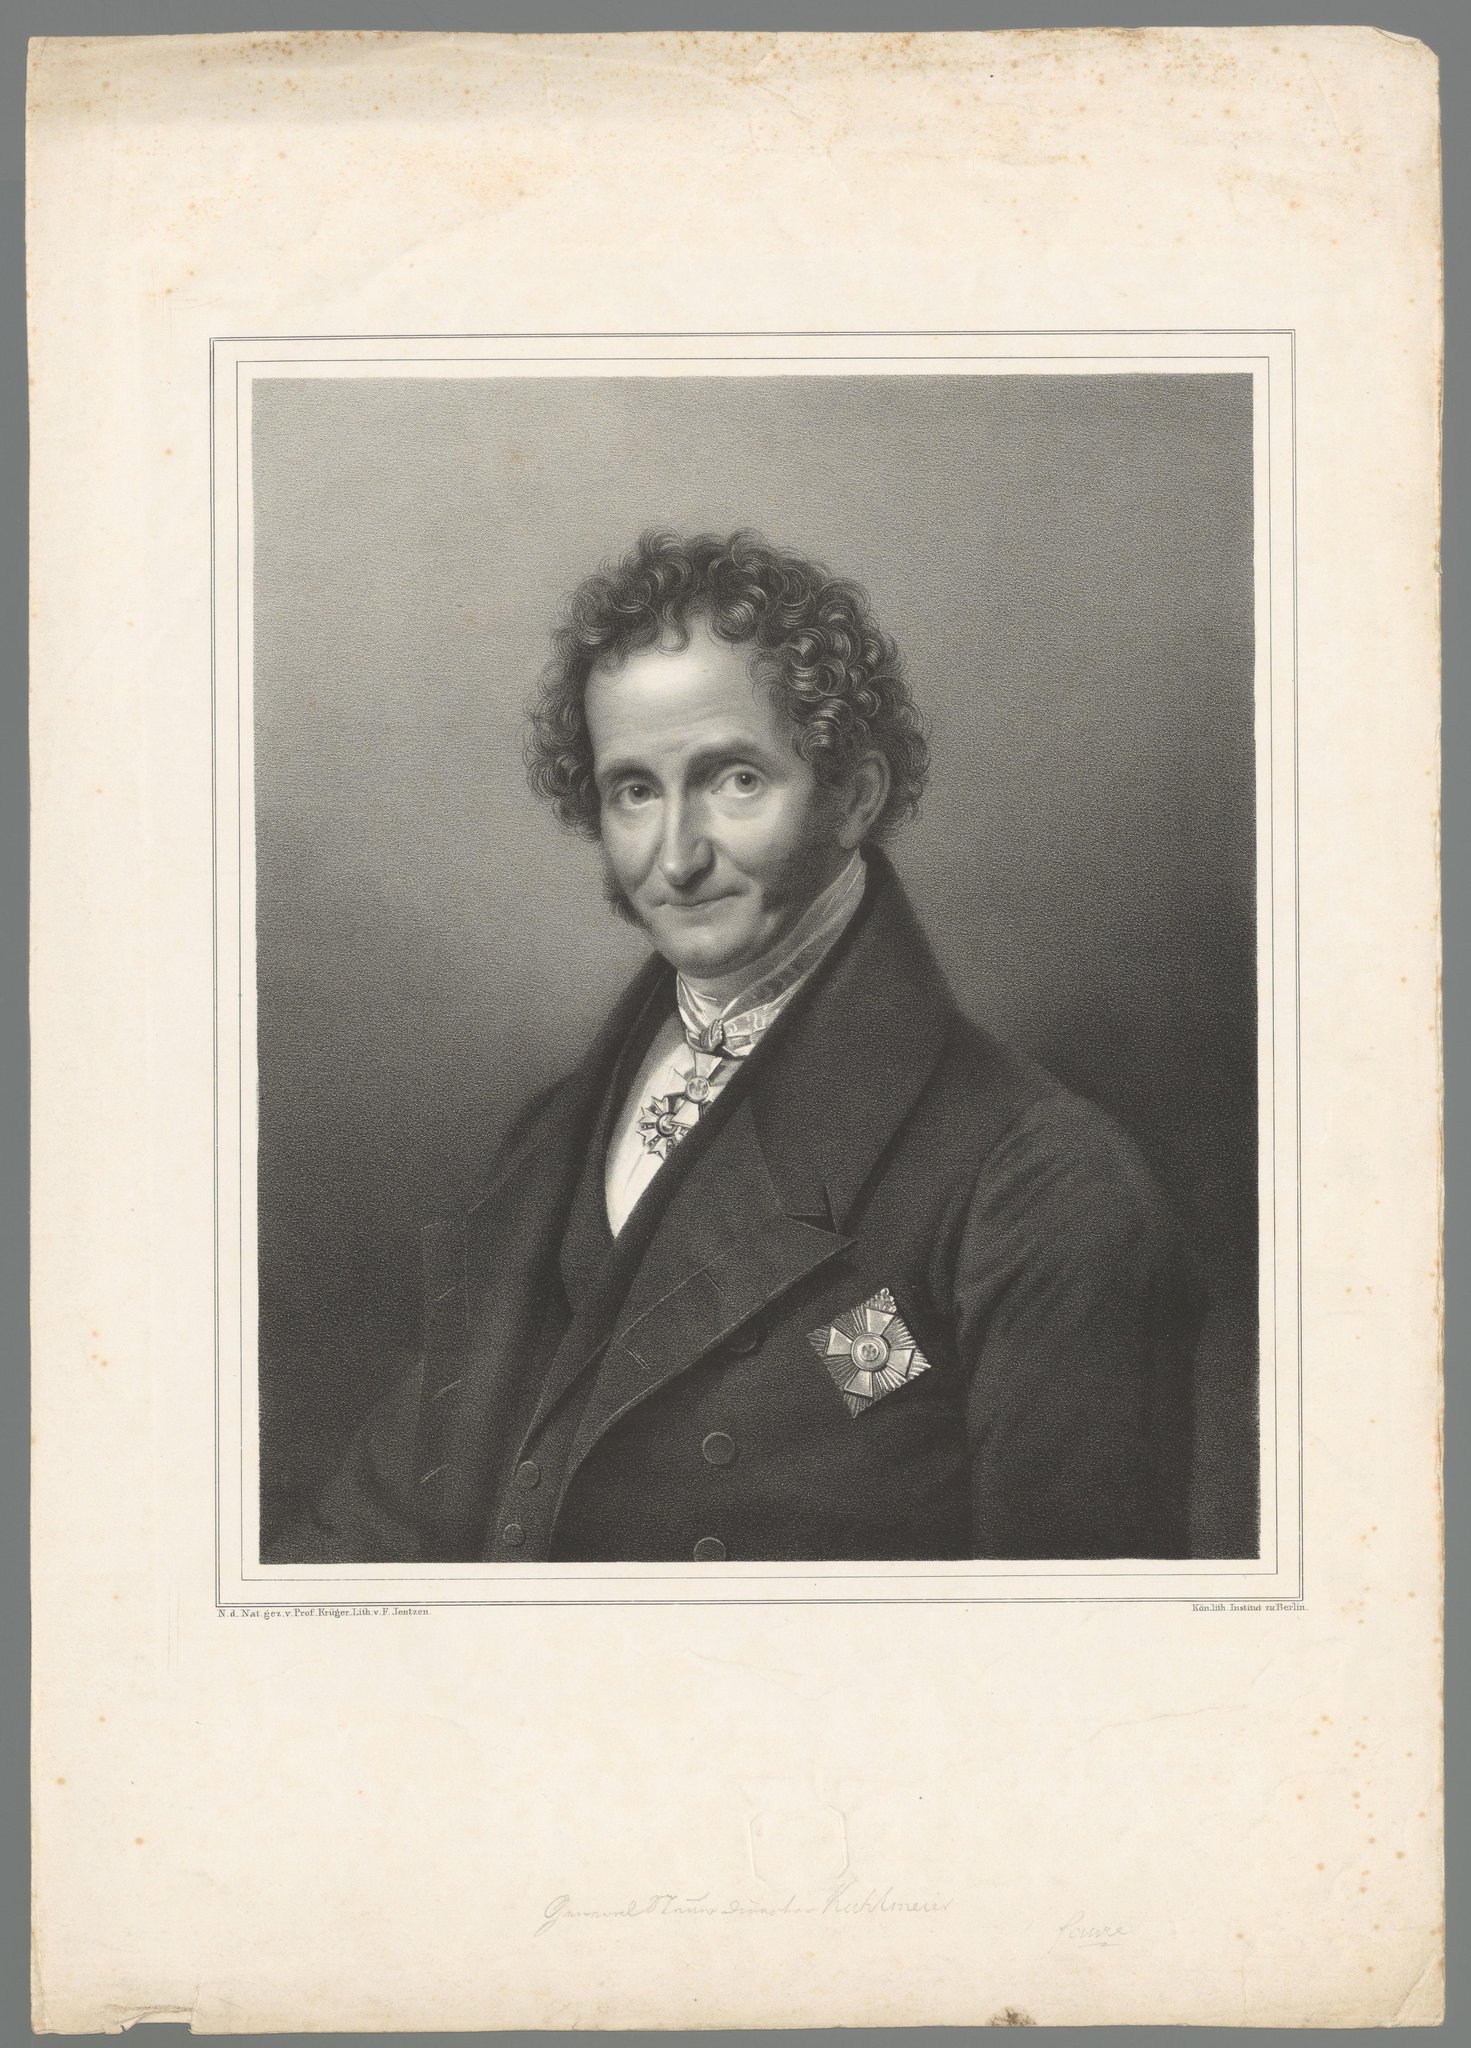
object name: print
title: Portret van Kuhlmeyer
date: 1814-1875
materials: paper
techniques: lithograph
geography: berlin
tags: adult man, historical persons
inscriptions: check stamp, collector's mark: Lugt 2228